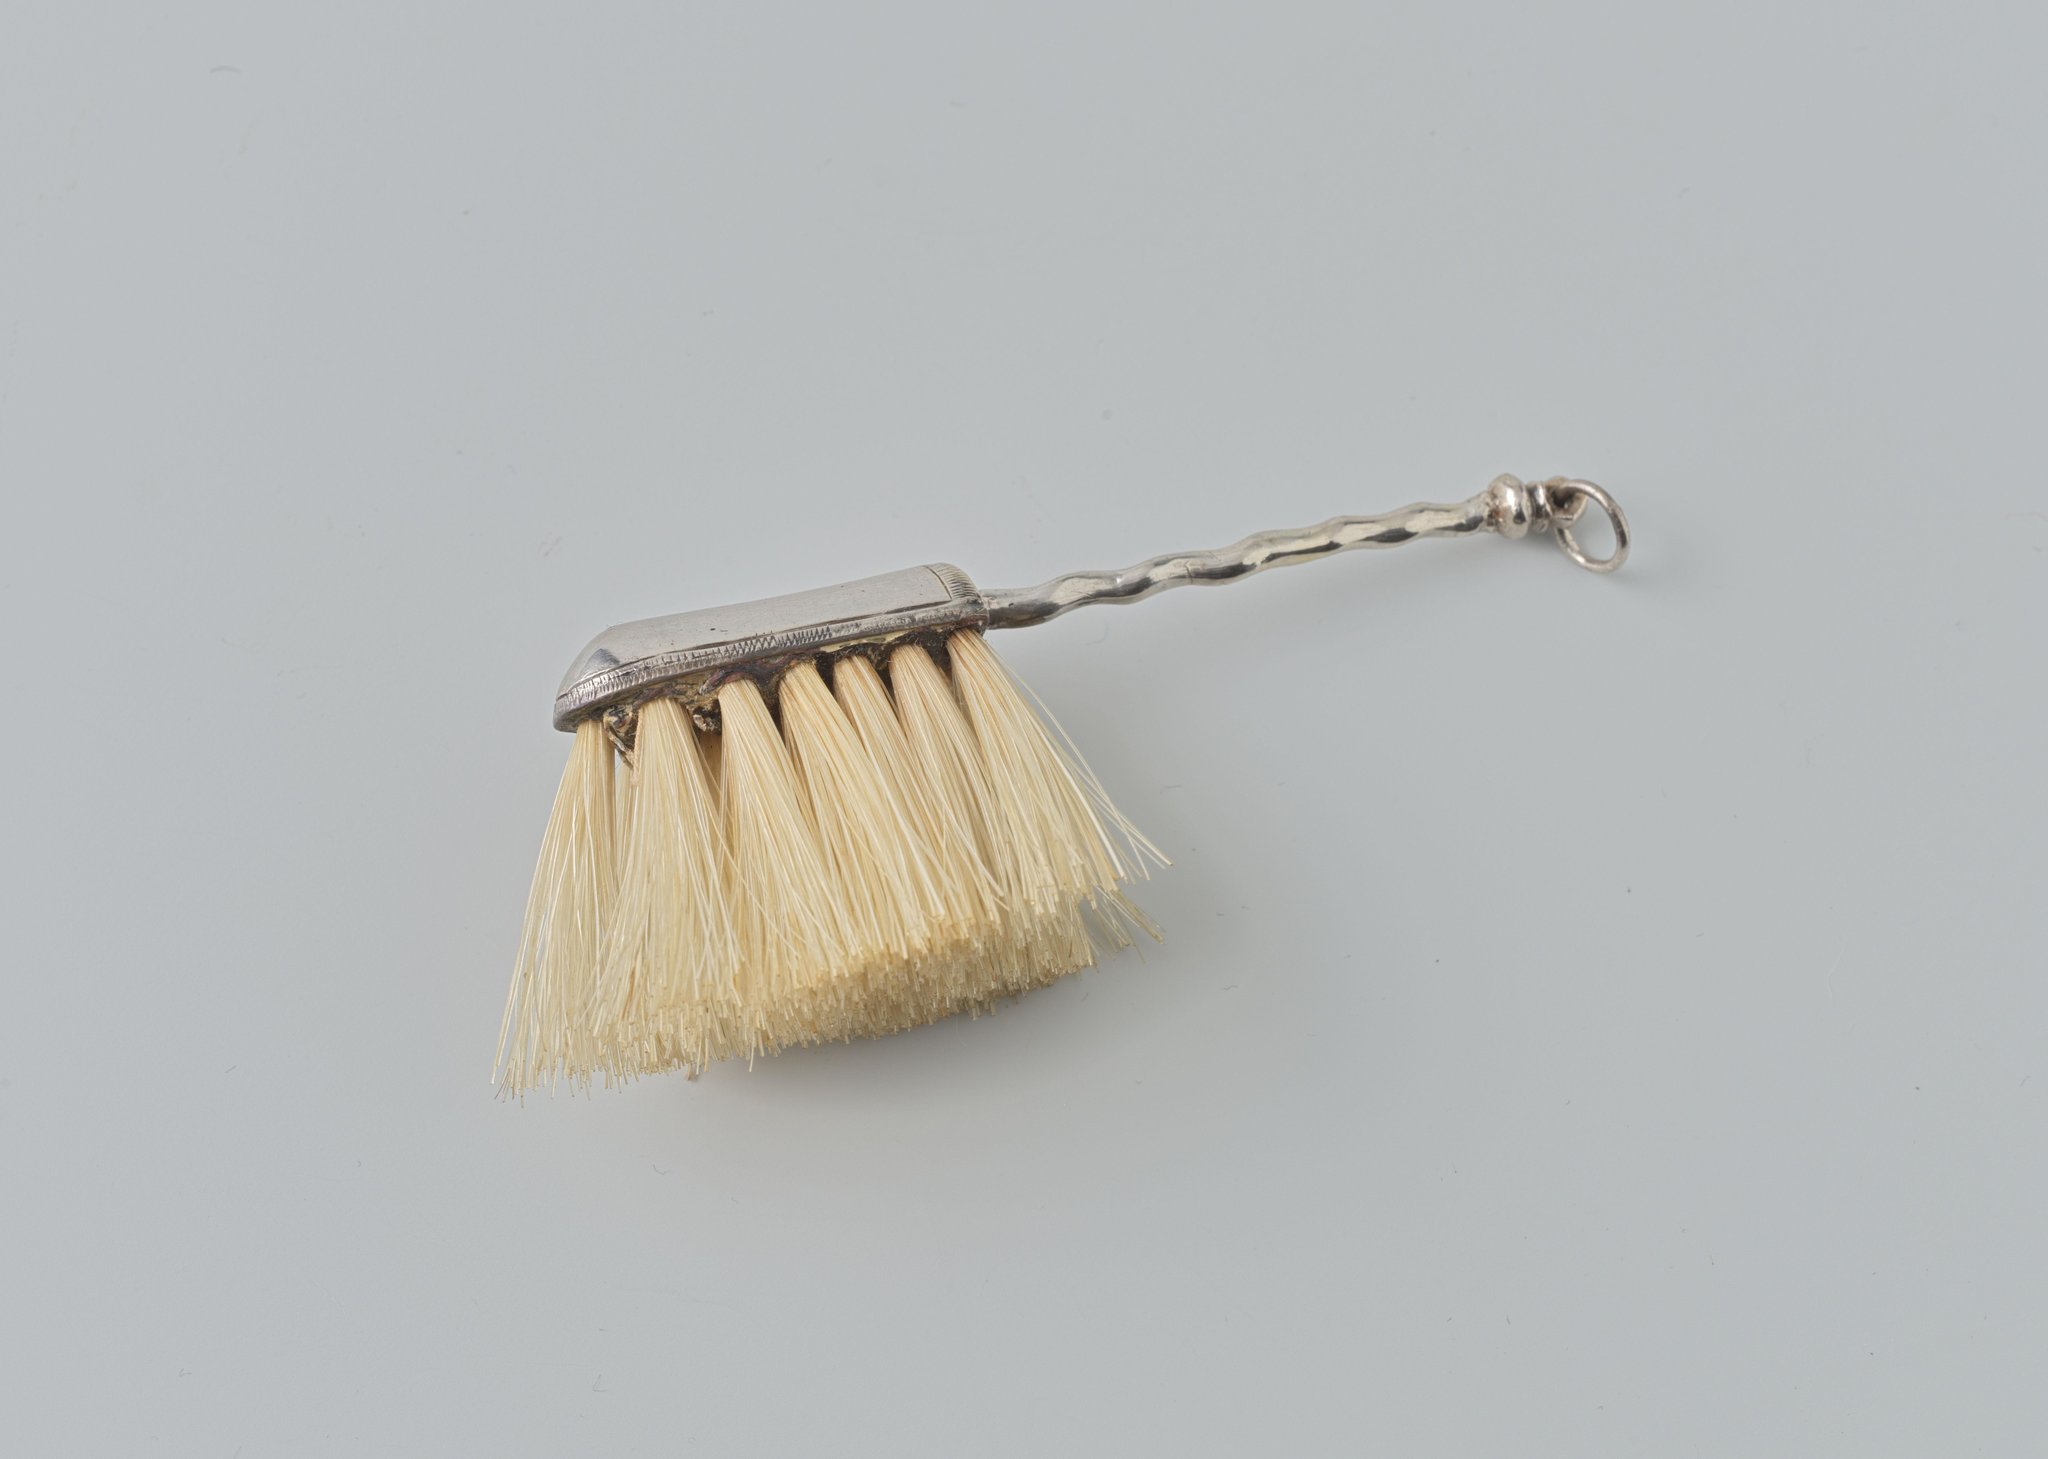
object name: miniature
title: Borstel of stoffer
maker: Anonymous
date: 1675-1700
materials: silver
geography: amsterdam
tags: dusting, sweeping (~ cleaning the house)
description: Stoffer of borstel van zilver en varkenshaar: gladde kop met tremblé-rand; getorste steel en ring.